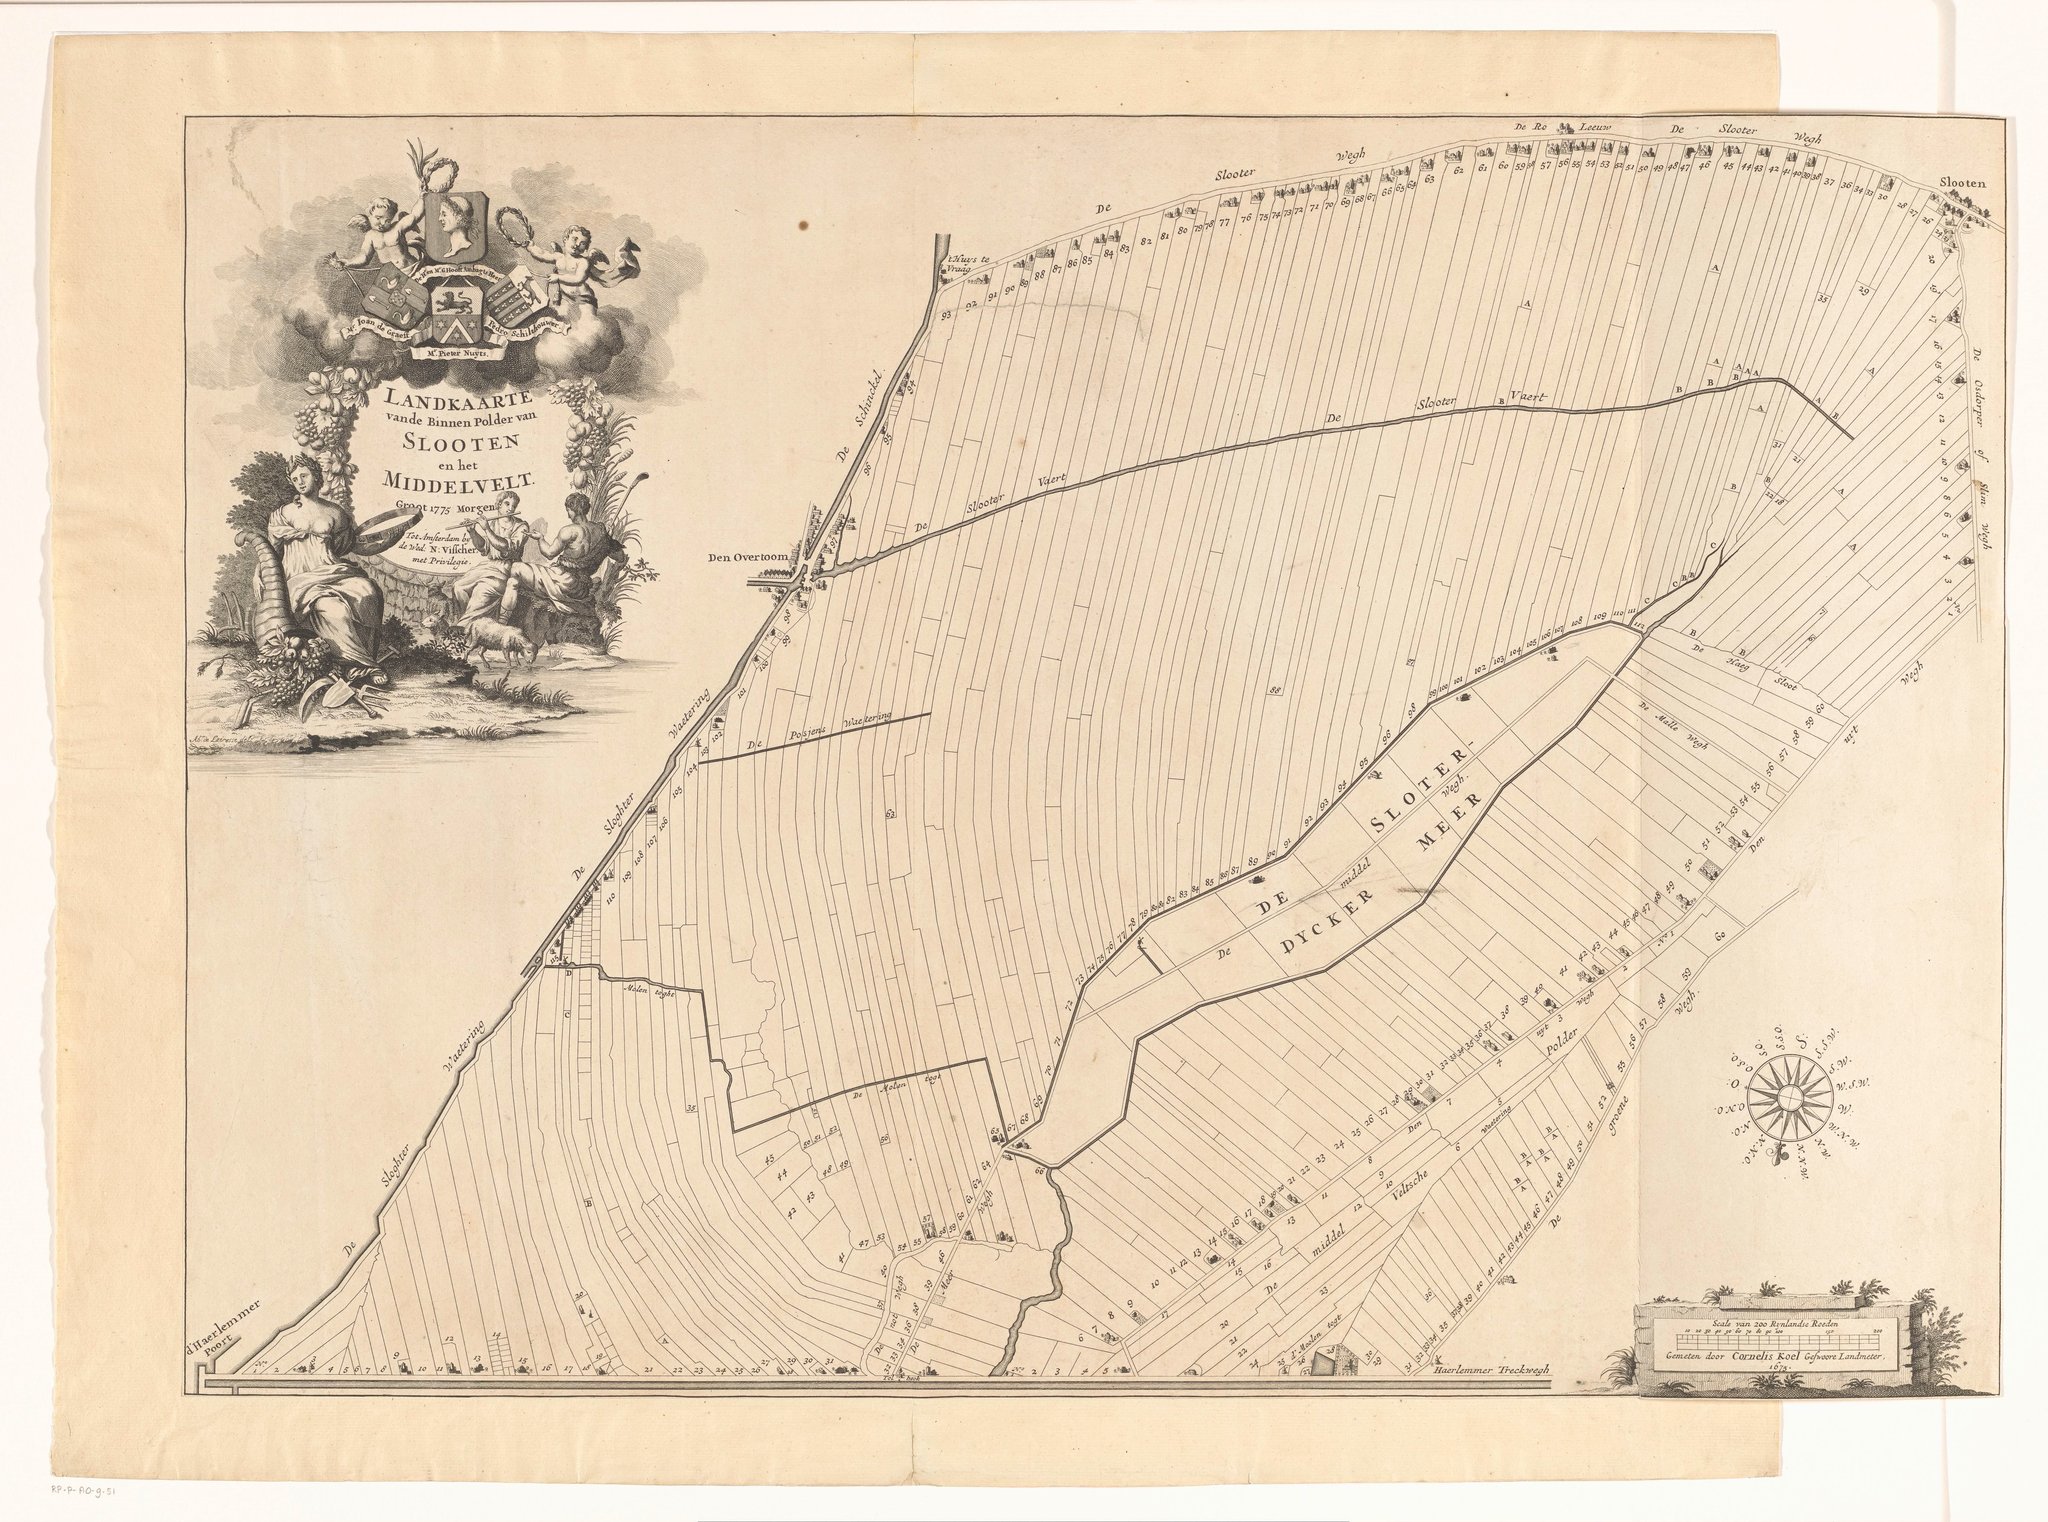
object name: map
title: Landkaarte vande binnen polder van Slooten en het Middelvelt. Groot 1775 morgen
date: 1702-1726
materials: paper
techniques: engraving, etching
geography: amsterdam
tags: maps of separate countries or regions, polder, reclaimed land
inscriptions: collector's mark: Lugt 195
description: Kaart van de Sloterbinnen- en Middelveldse gecombineerde polders met kavelverdeling, volgens metingen van 1675. Linksboven de titelcartouche met daaromheen een allegorische voorstelling en daarboven vier wapenschilden, waaronder dat van de ambachtsheer. Rechtsonder een schaalstok: Scale van 200 Rynlandse roeden. Oriëntatie: noorden onder.